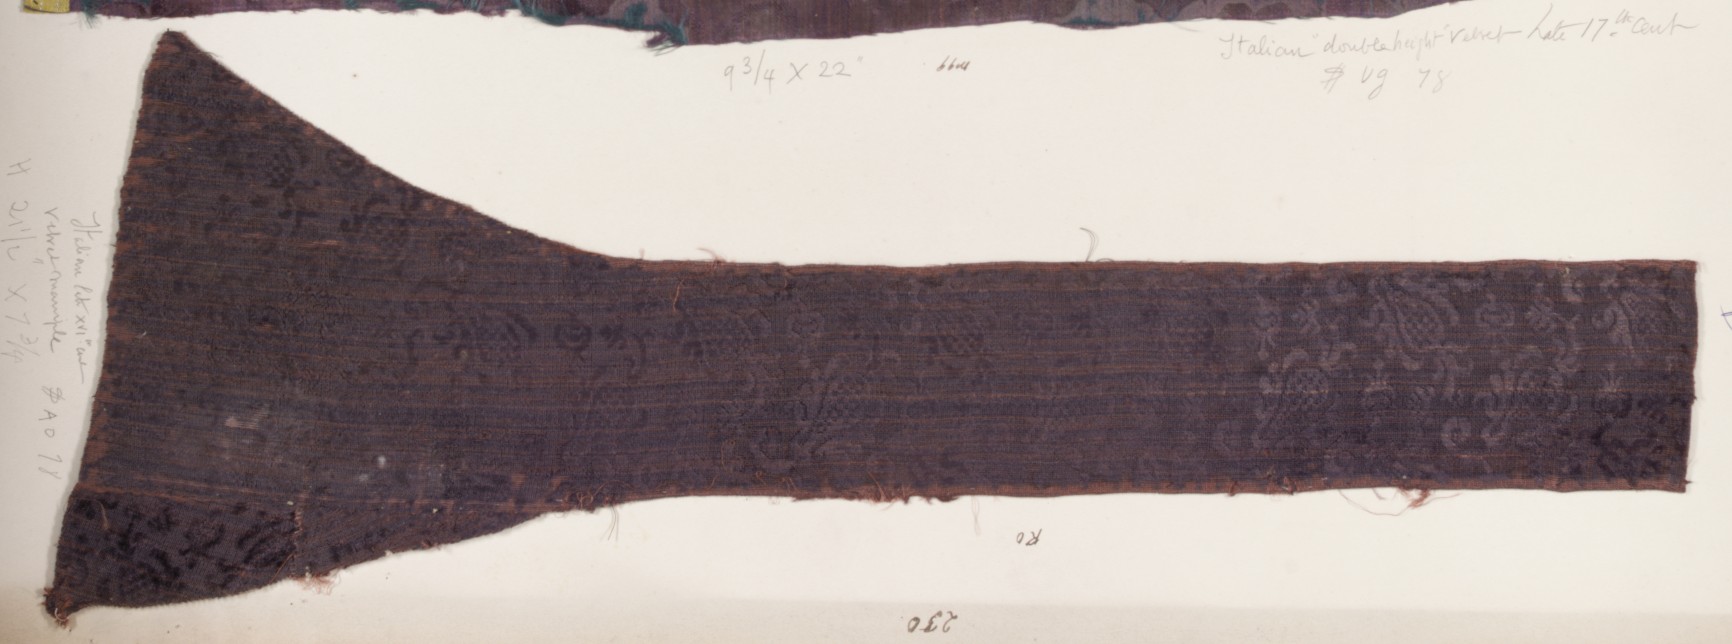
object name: fragment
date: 1567-1600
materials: silk